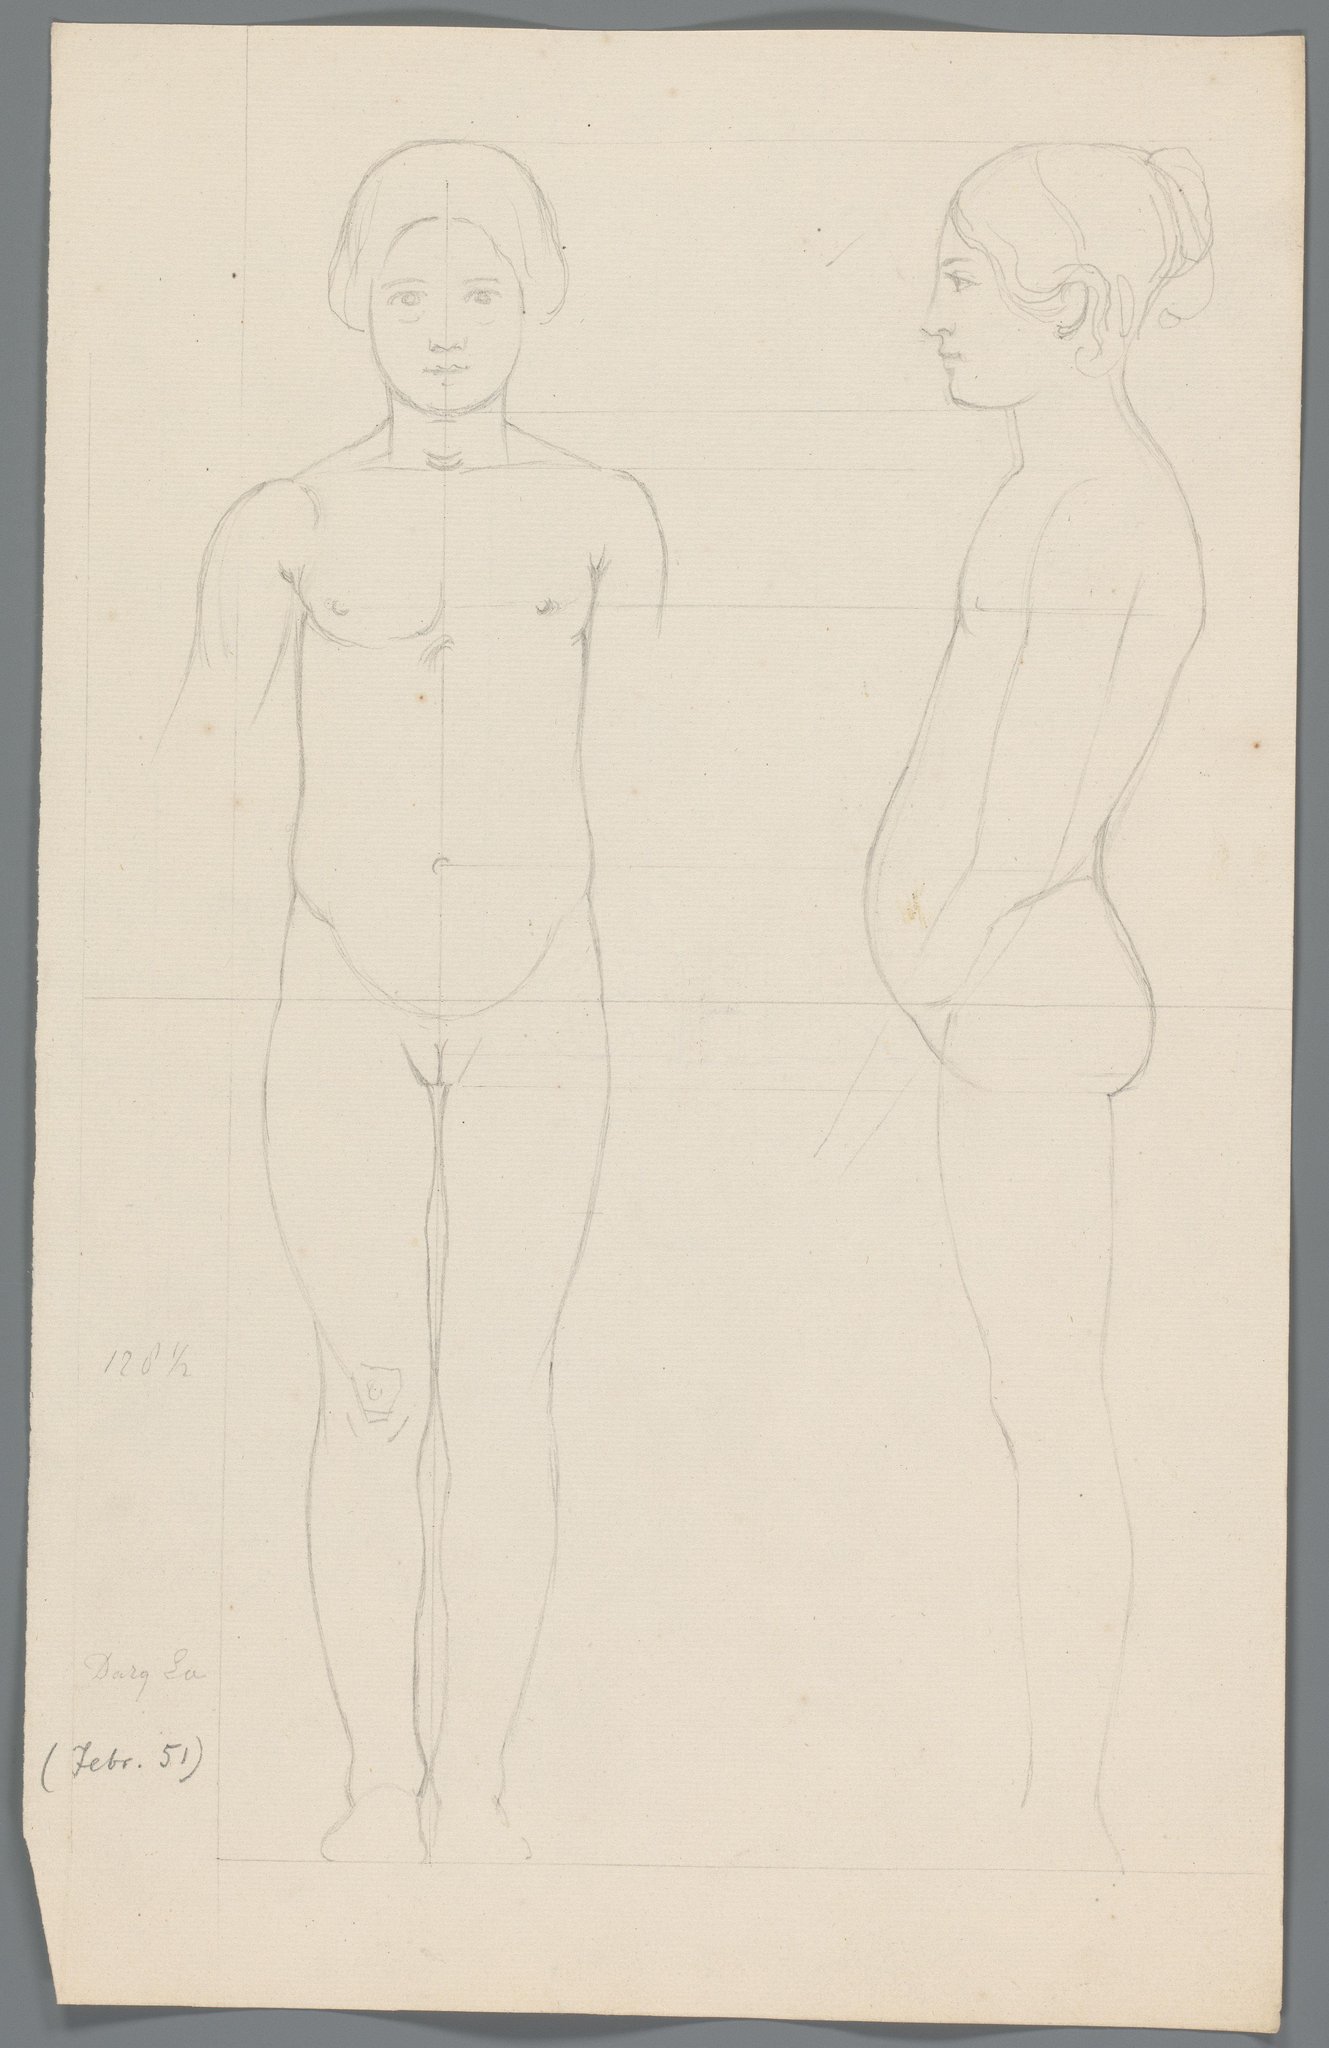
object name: drawing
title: Proportiestudie van een meisje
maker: jacobus everhardus josephus van den berg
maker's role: draughtsman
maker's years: 1802-1861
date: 1851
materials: paper, pencil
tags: standing figure (canon, proportions) - aa - female human figure, anatomy (non-medical) - aa - female human figure, child (at home) - aa - girl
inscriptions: inscription: ‘Darg Ea/ Febr 51’